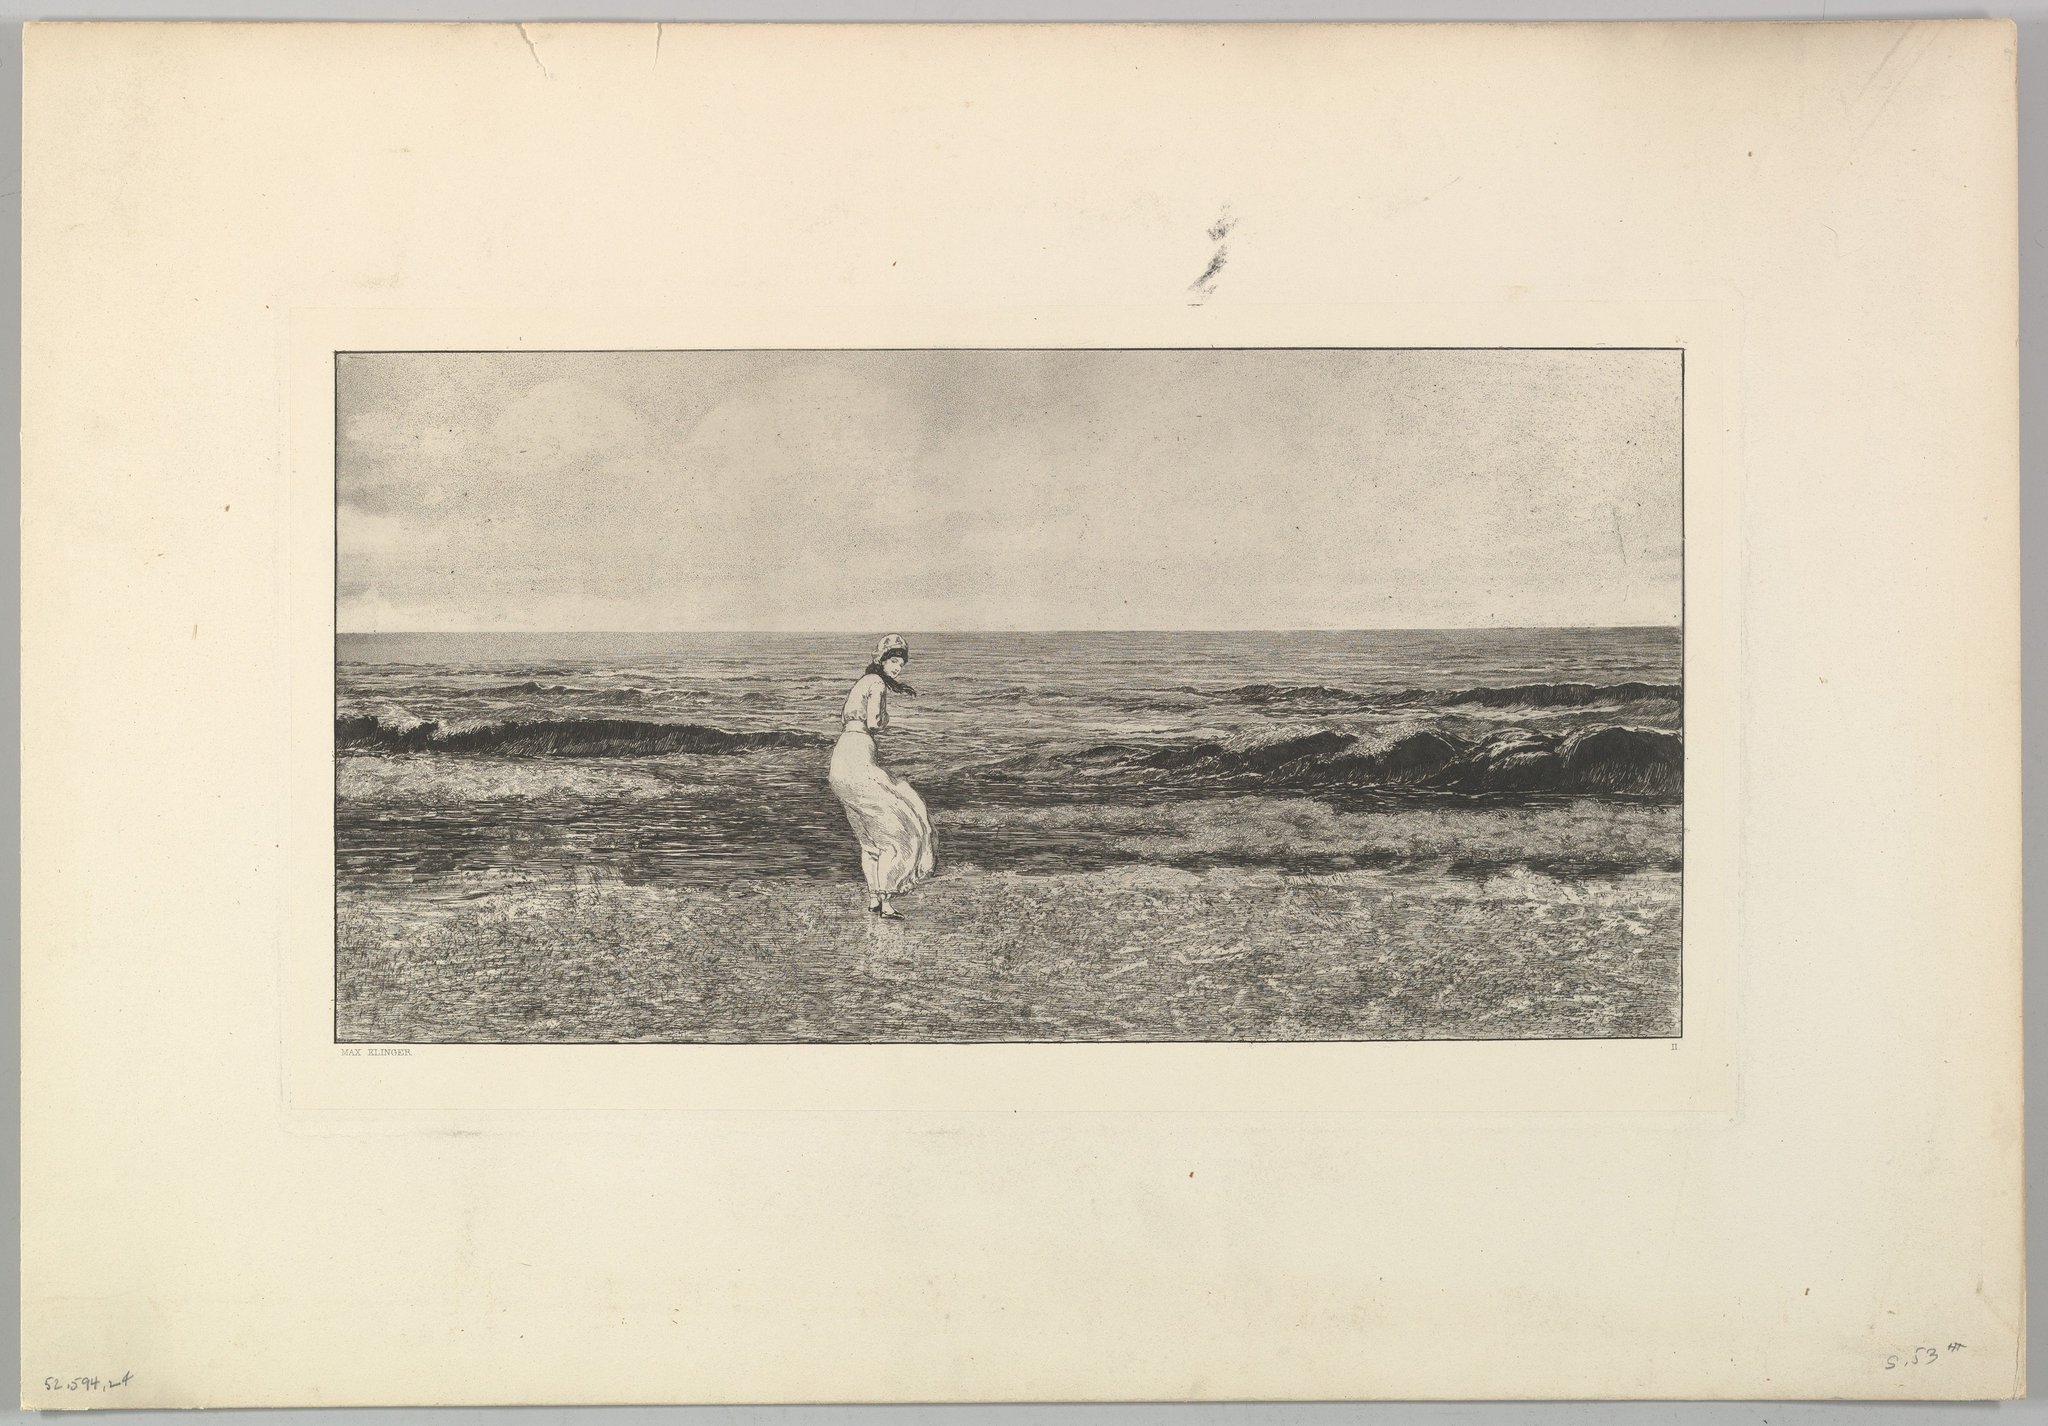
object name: print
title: Am Meer, from the series Intermezzi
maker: max klinger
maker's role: artist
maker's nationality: german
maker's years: 1857-1920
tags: women,waves